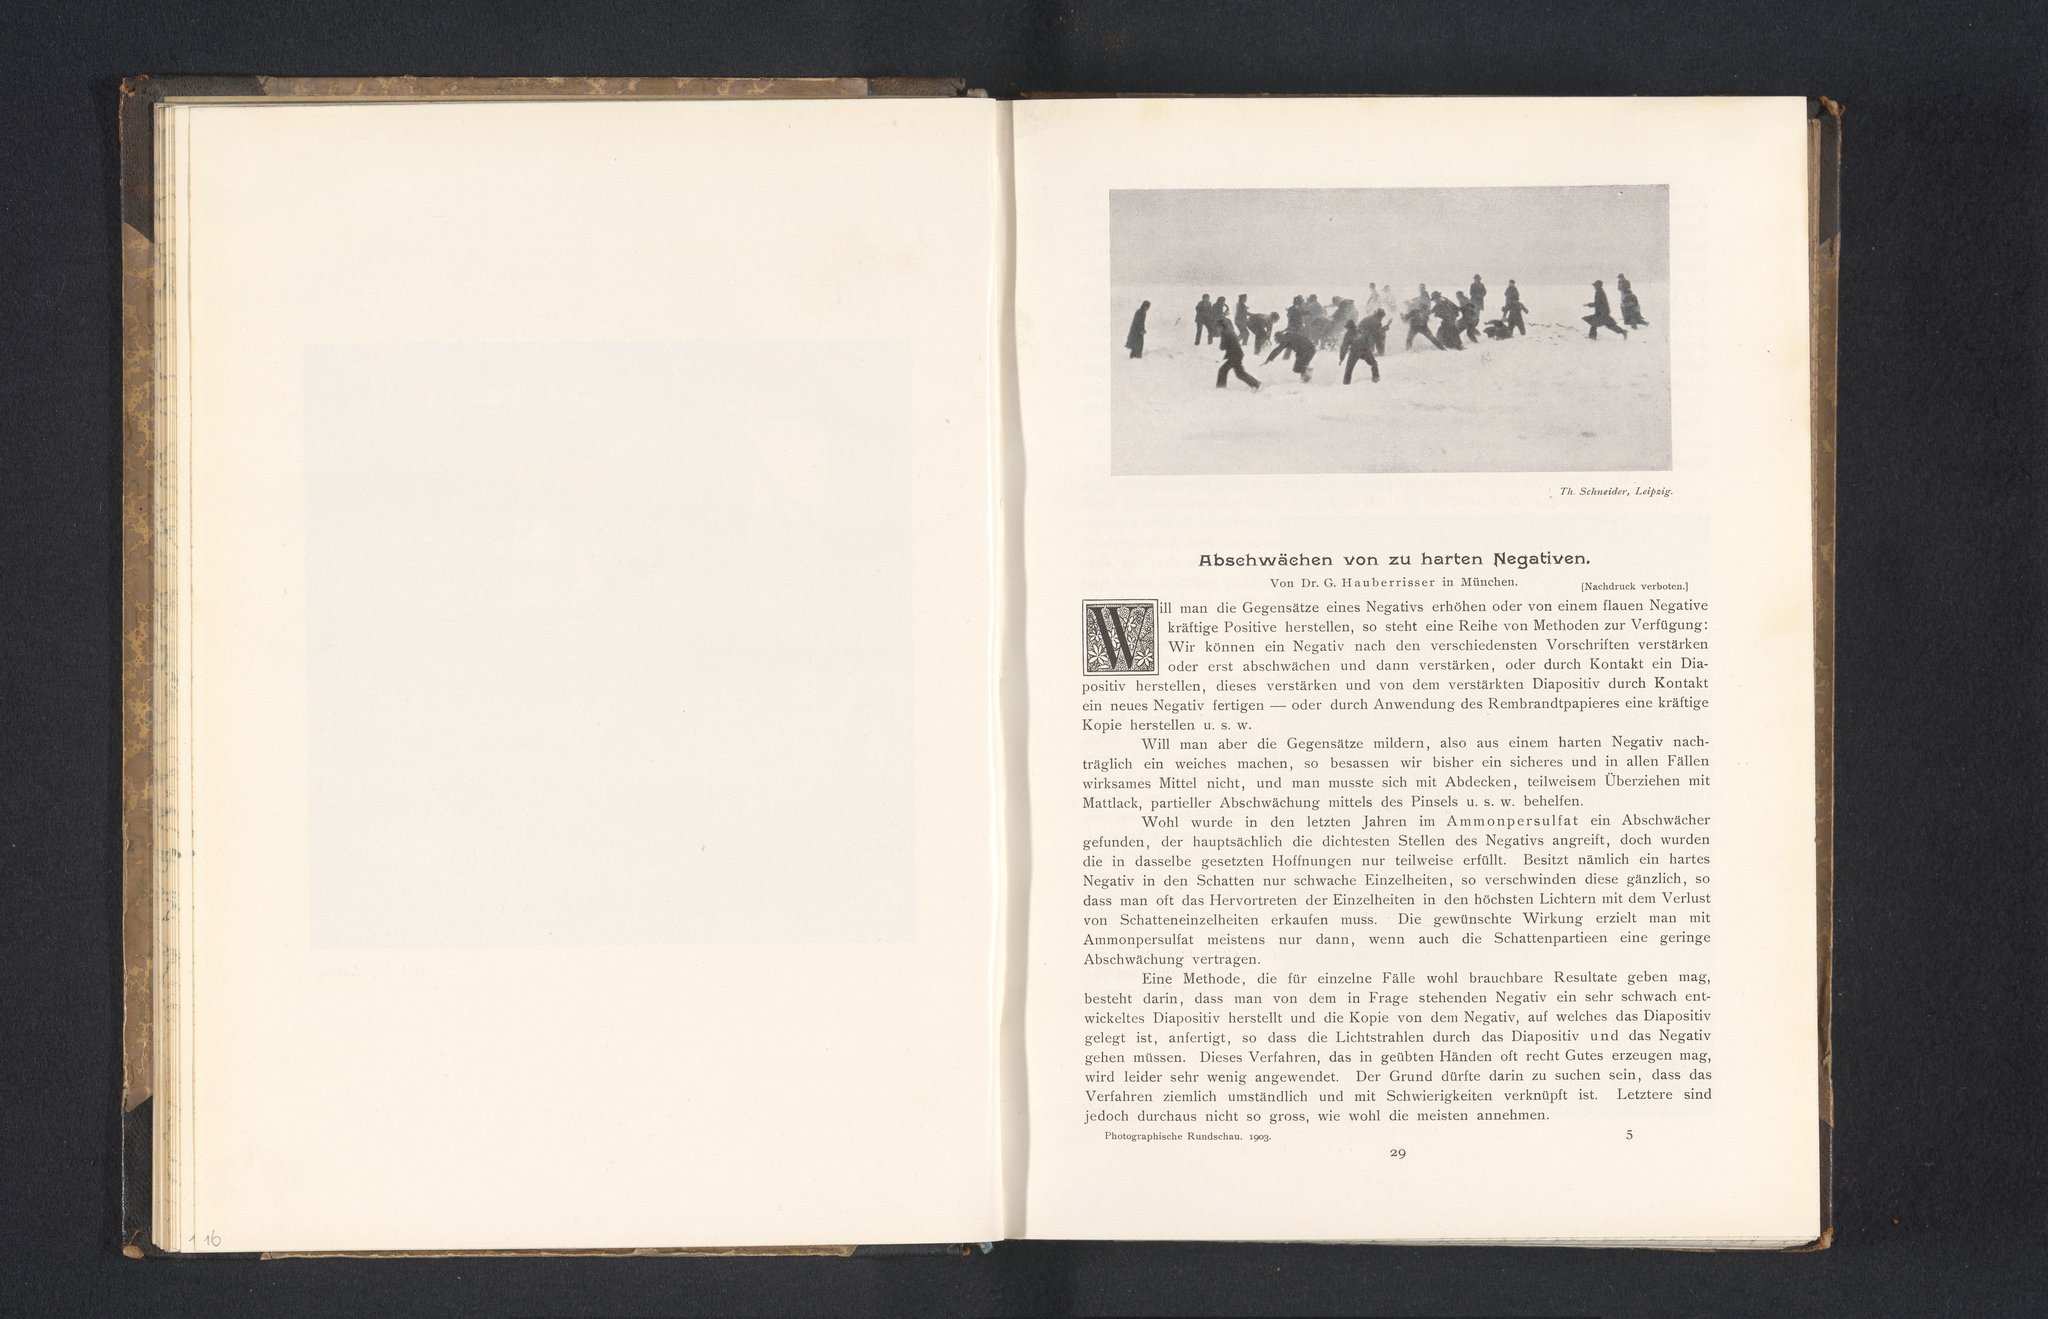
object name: page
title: Groep mannen houdt een sneeuwballengevecht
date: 1898-1903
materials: paper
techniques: autotype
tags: throwing snowballs - cc - adult(s) ~ snow and ice